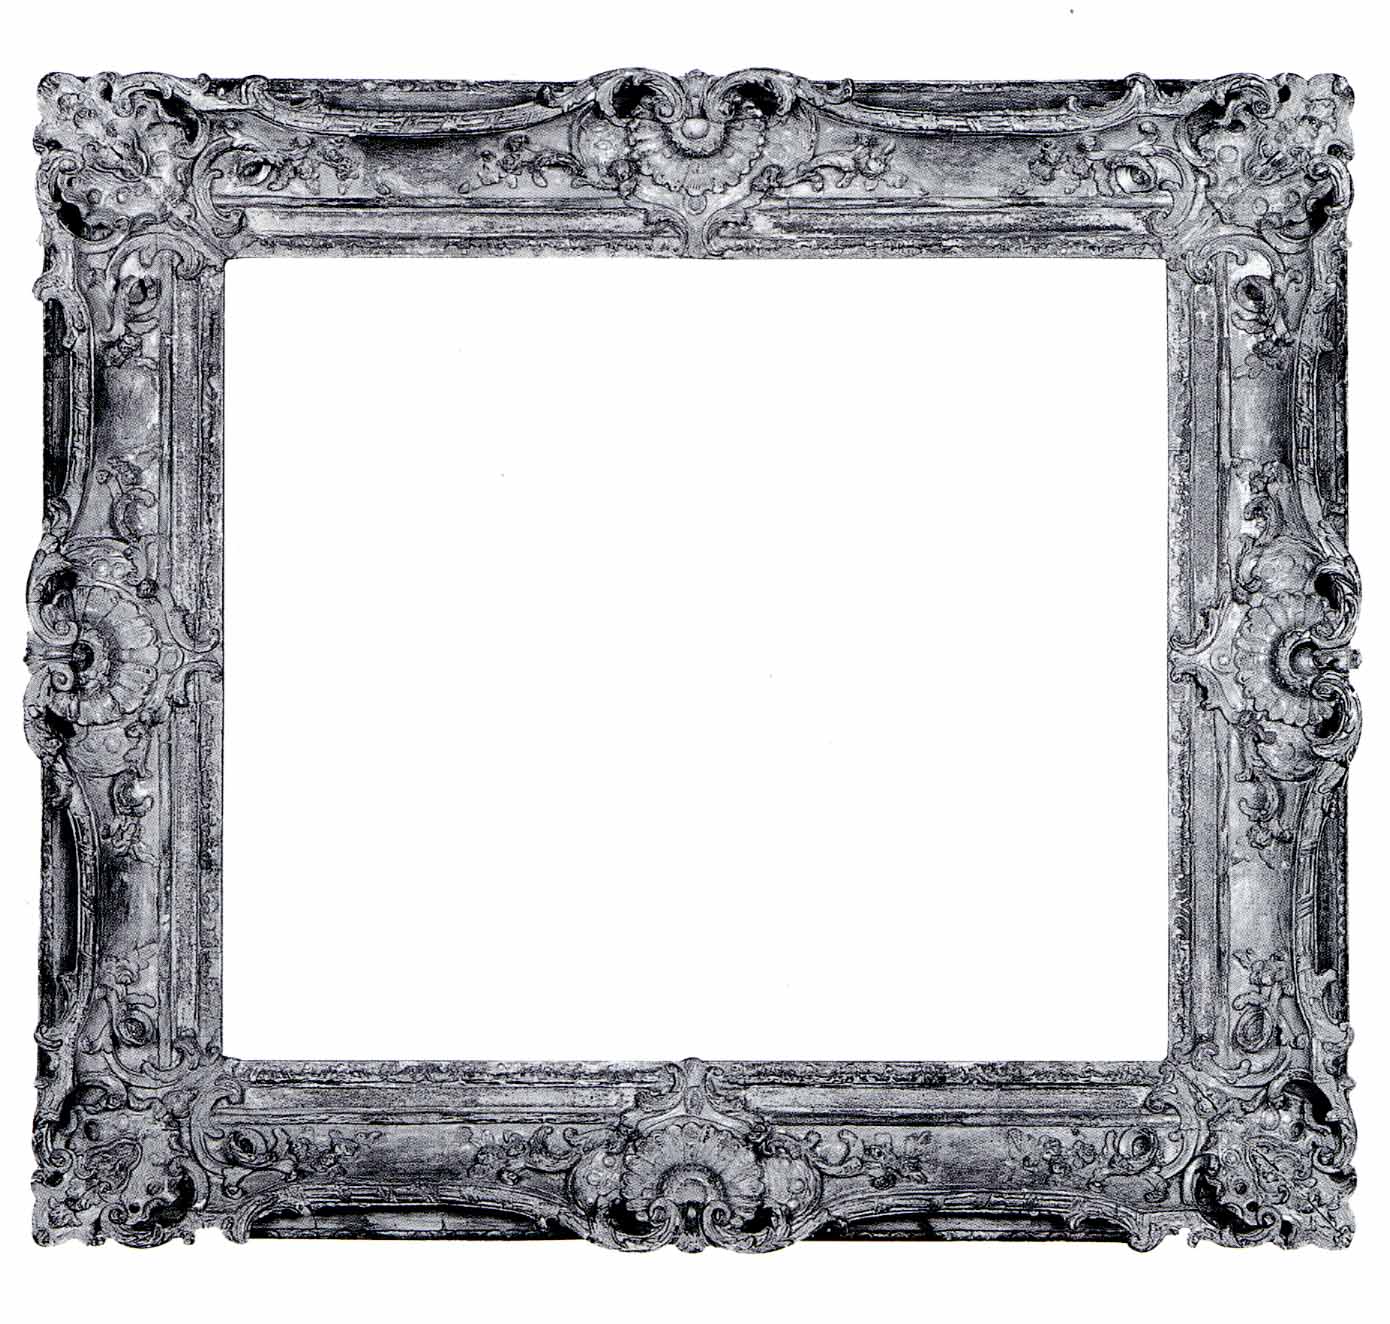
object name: frame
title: Swept frame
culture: french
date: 1730-1740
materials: feather, gilt, wood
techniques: carving